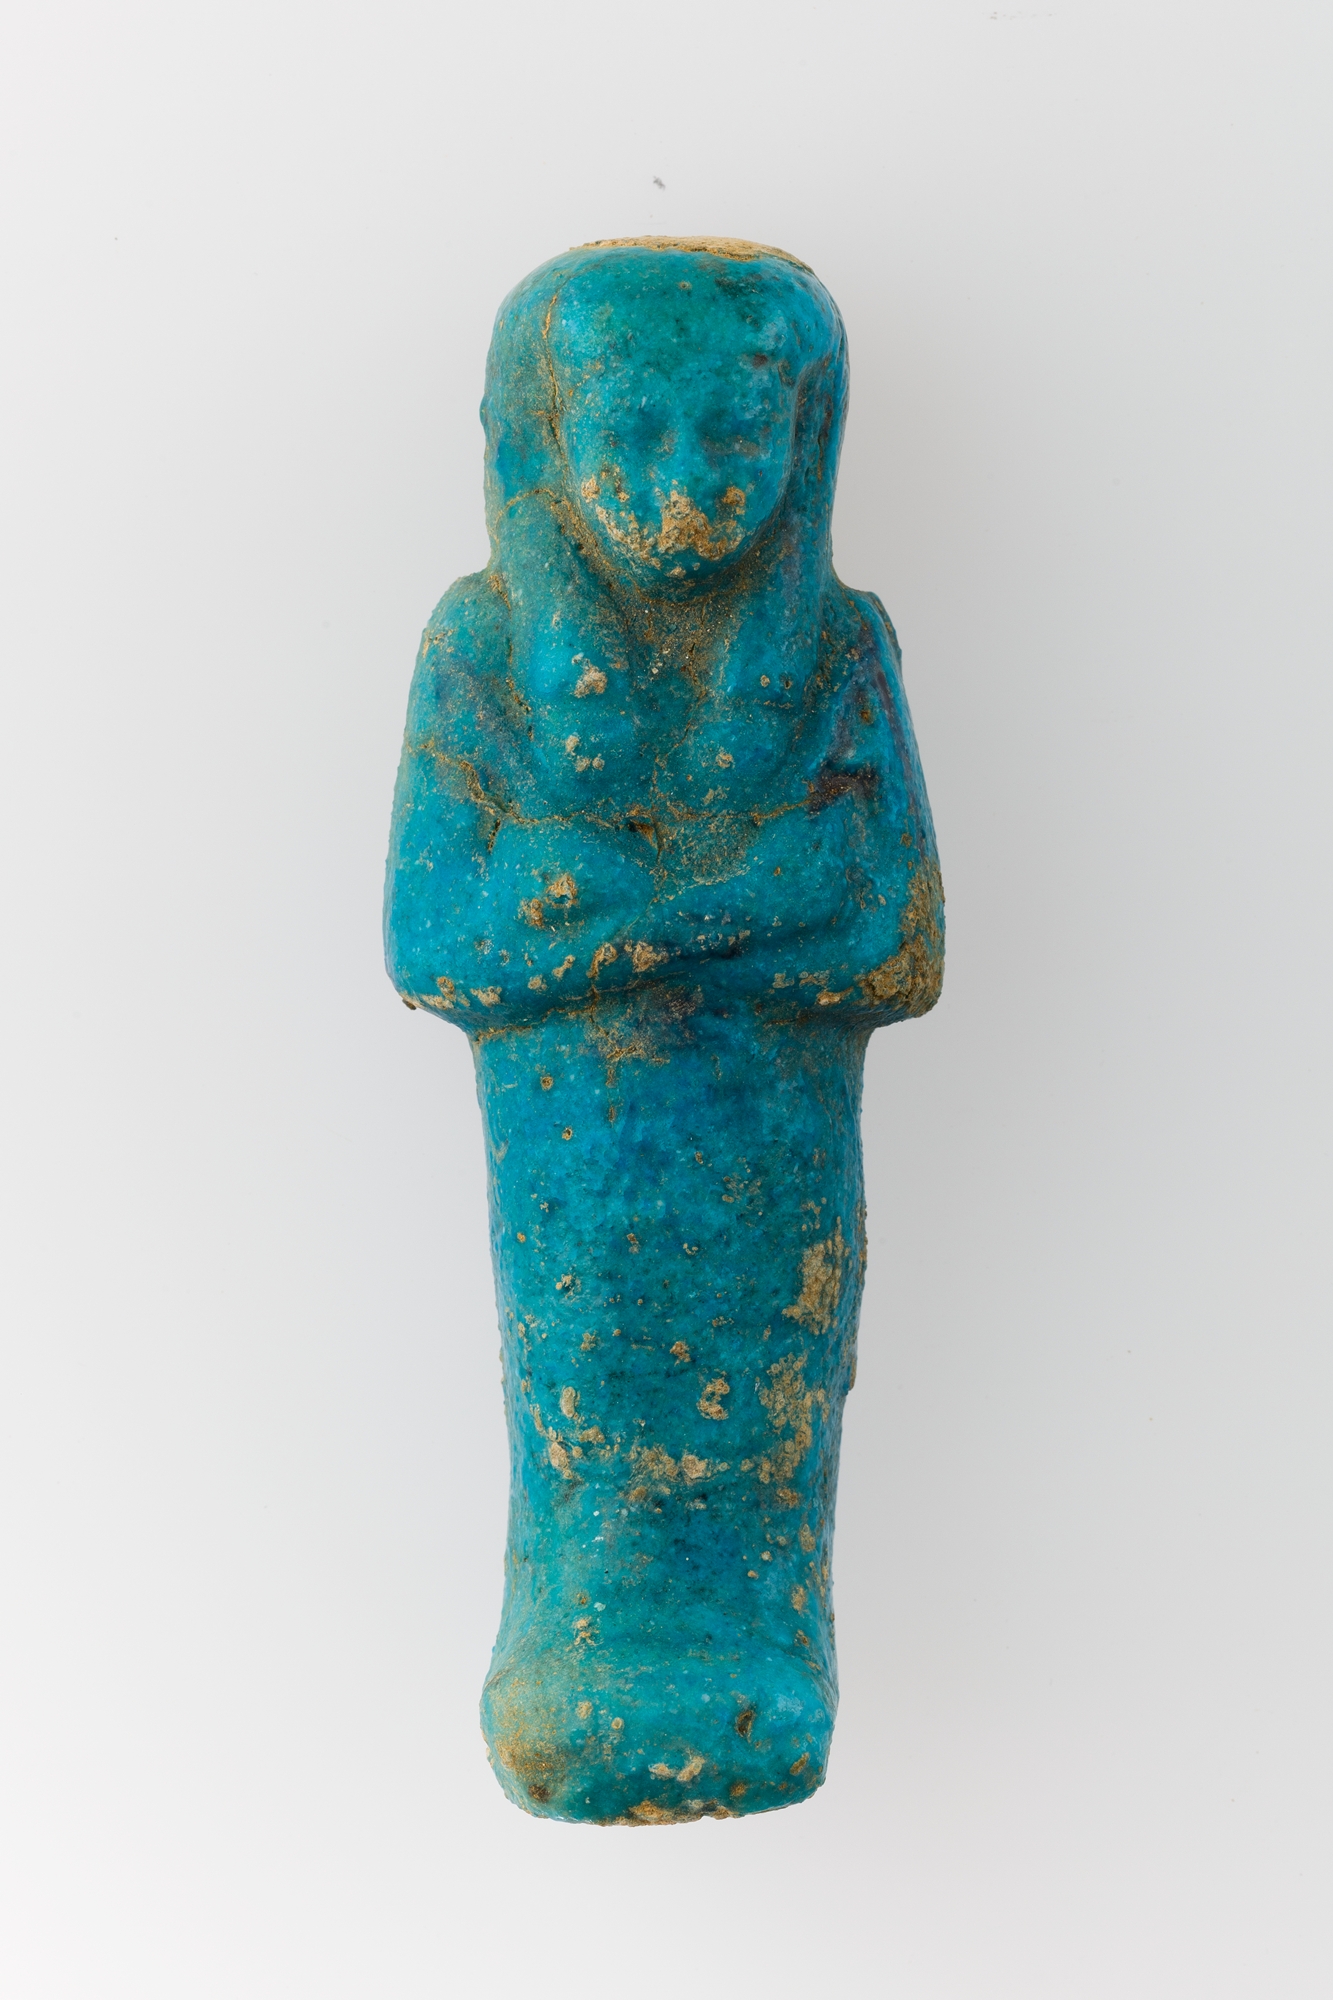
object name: shabti, henettawy c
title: Worker Shabti of Henettawy (C), Daughter of Isetemkheb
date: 990-970 BCE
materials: faience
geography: egypt